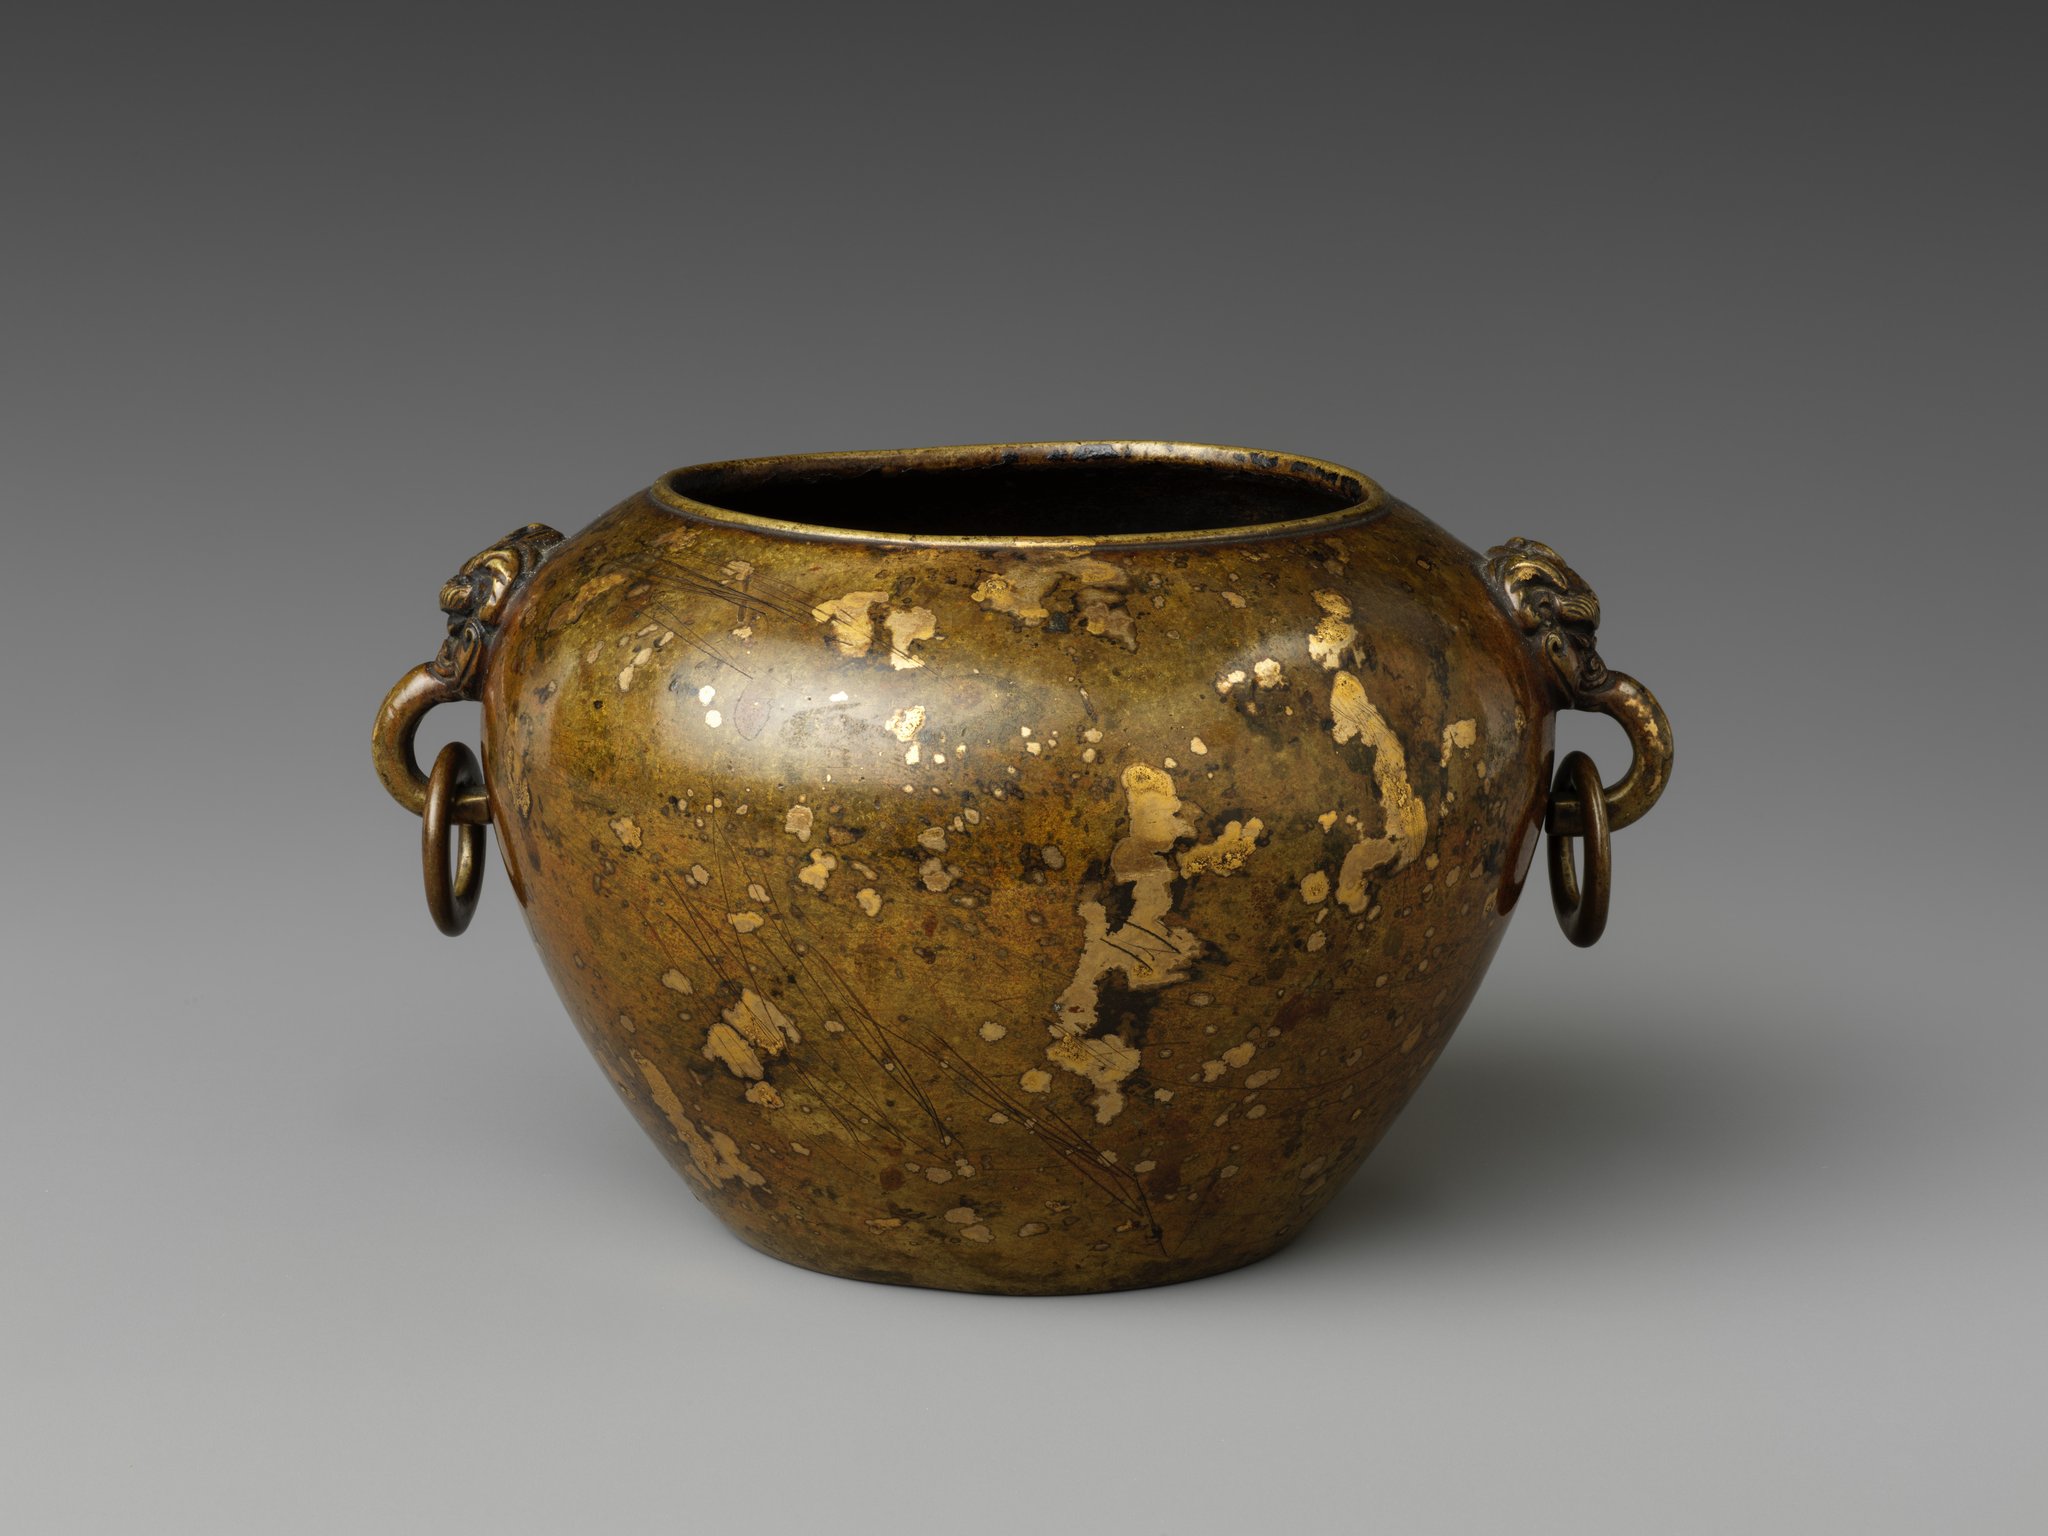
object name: incense burner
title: Incense burner with animal-mask handles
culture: chinese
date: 1601-1700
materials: copper alloy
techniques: gilding